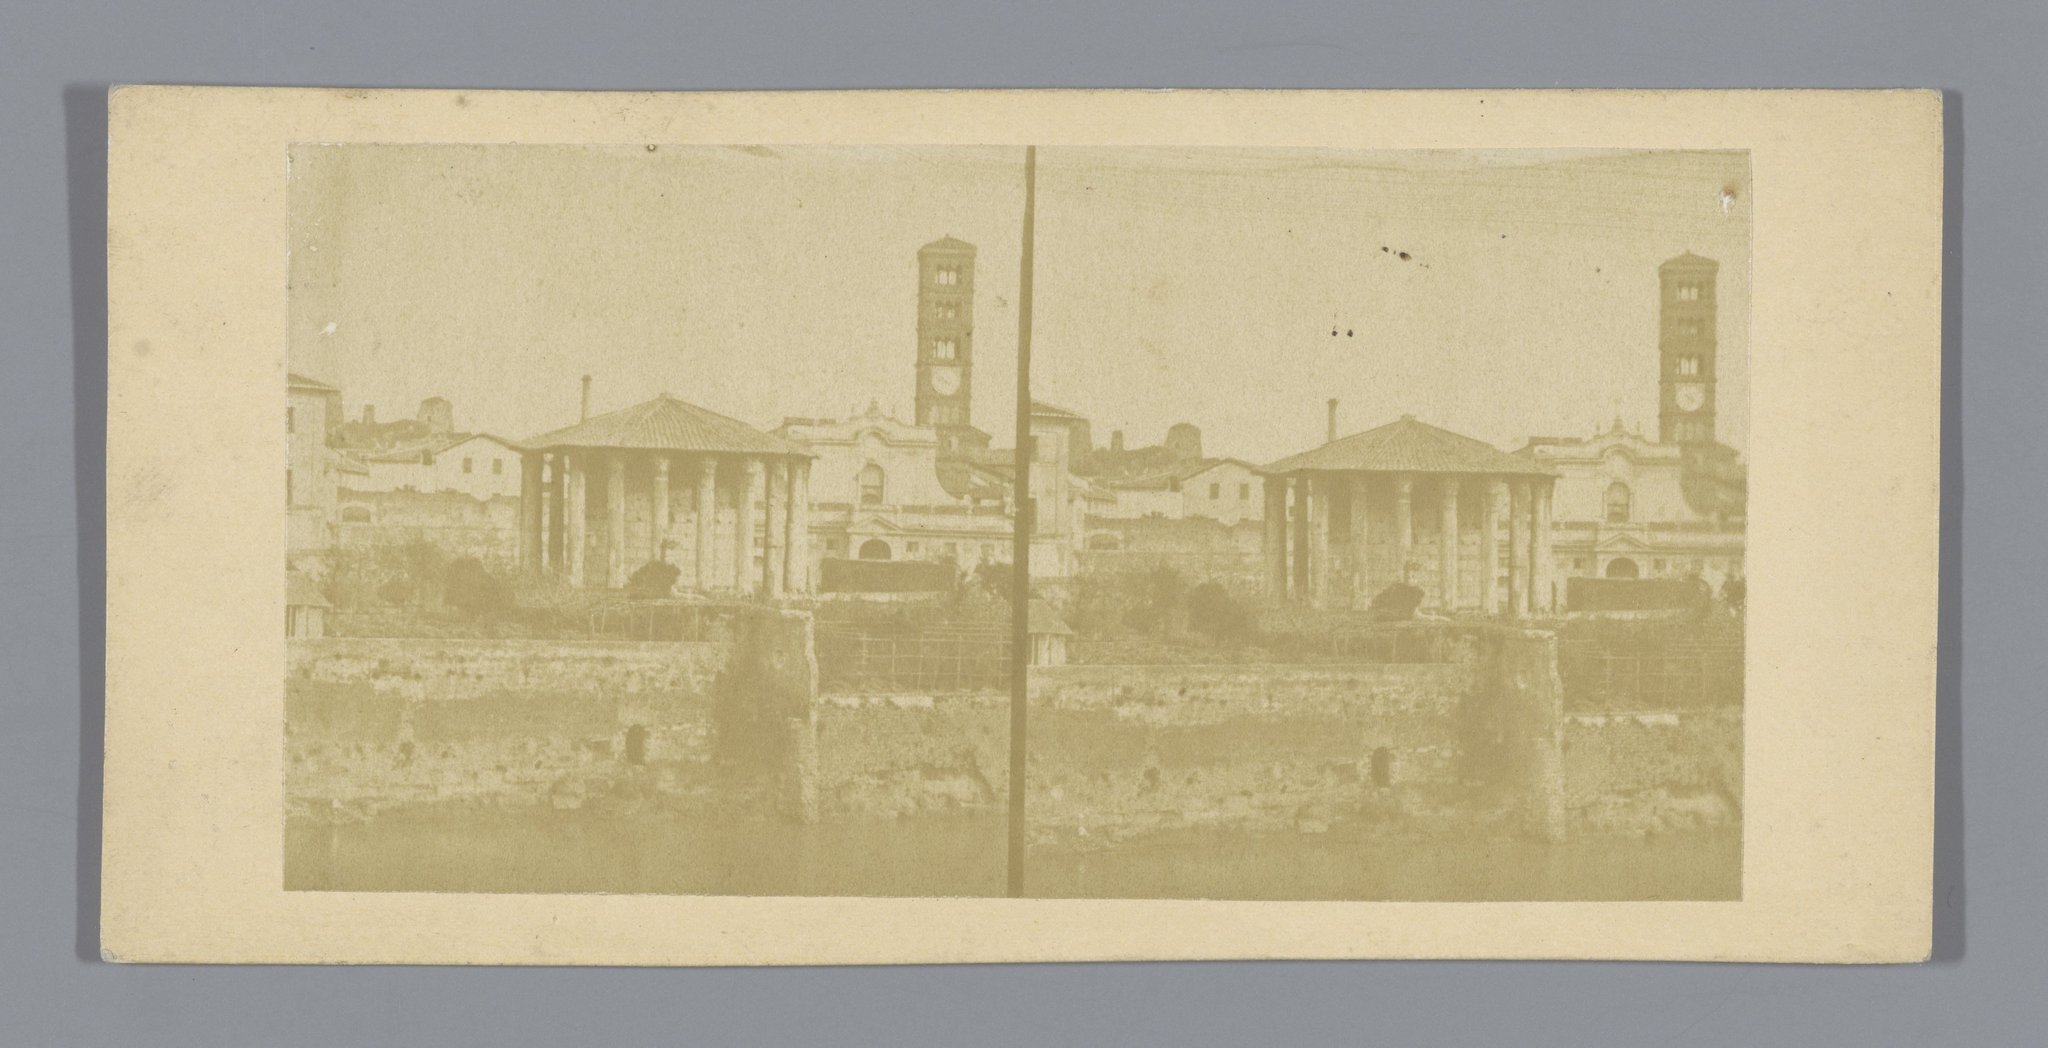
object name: stereograph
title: Gezicht op de Tempel van Hercules Invictus te Rome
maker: Anonymous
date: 1850-1880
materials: cardboard, photographic support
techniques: albumen print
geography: rome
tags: tower, clock tower ~ monumental adornment, temple, shrine ~ non-christian religions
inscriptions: number: ‘6’